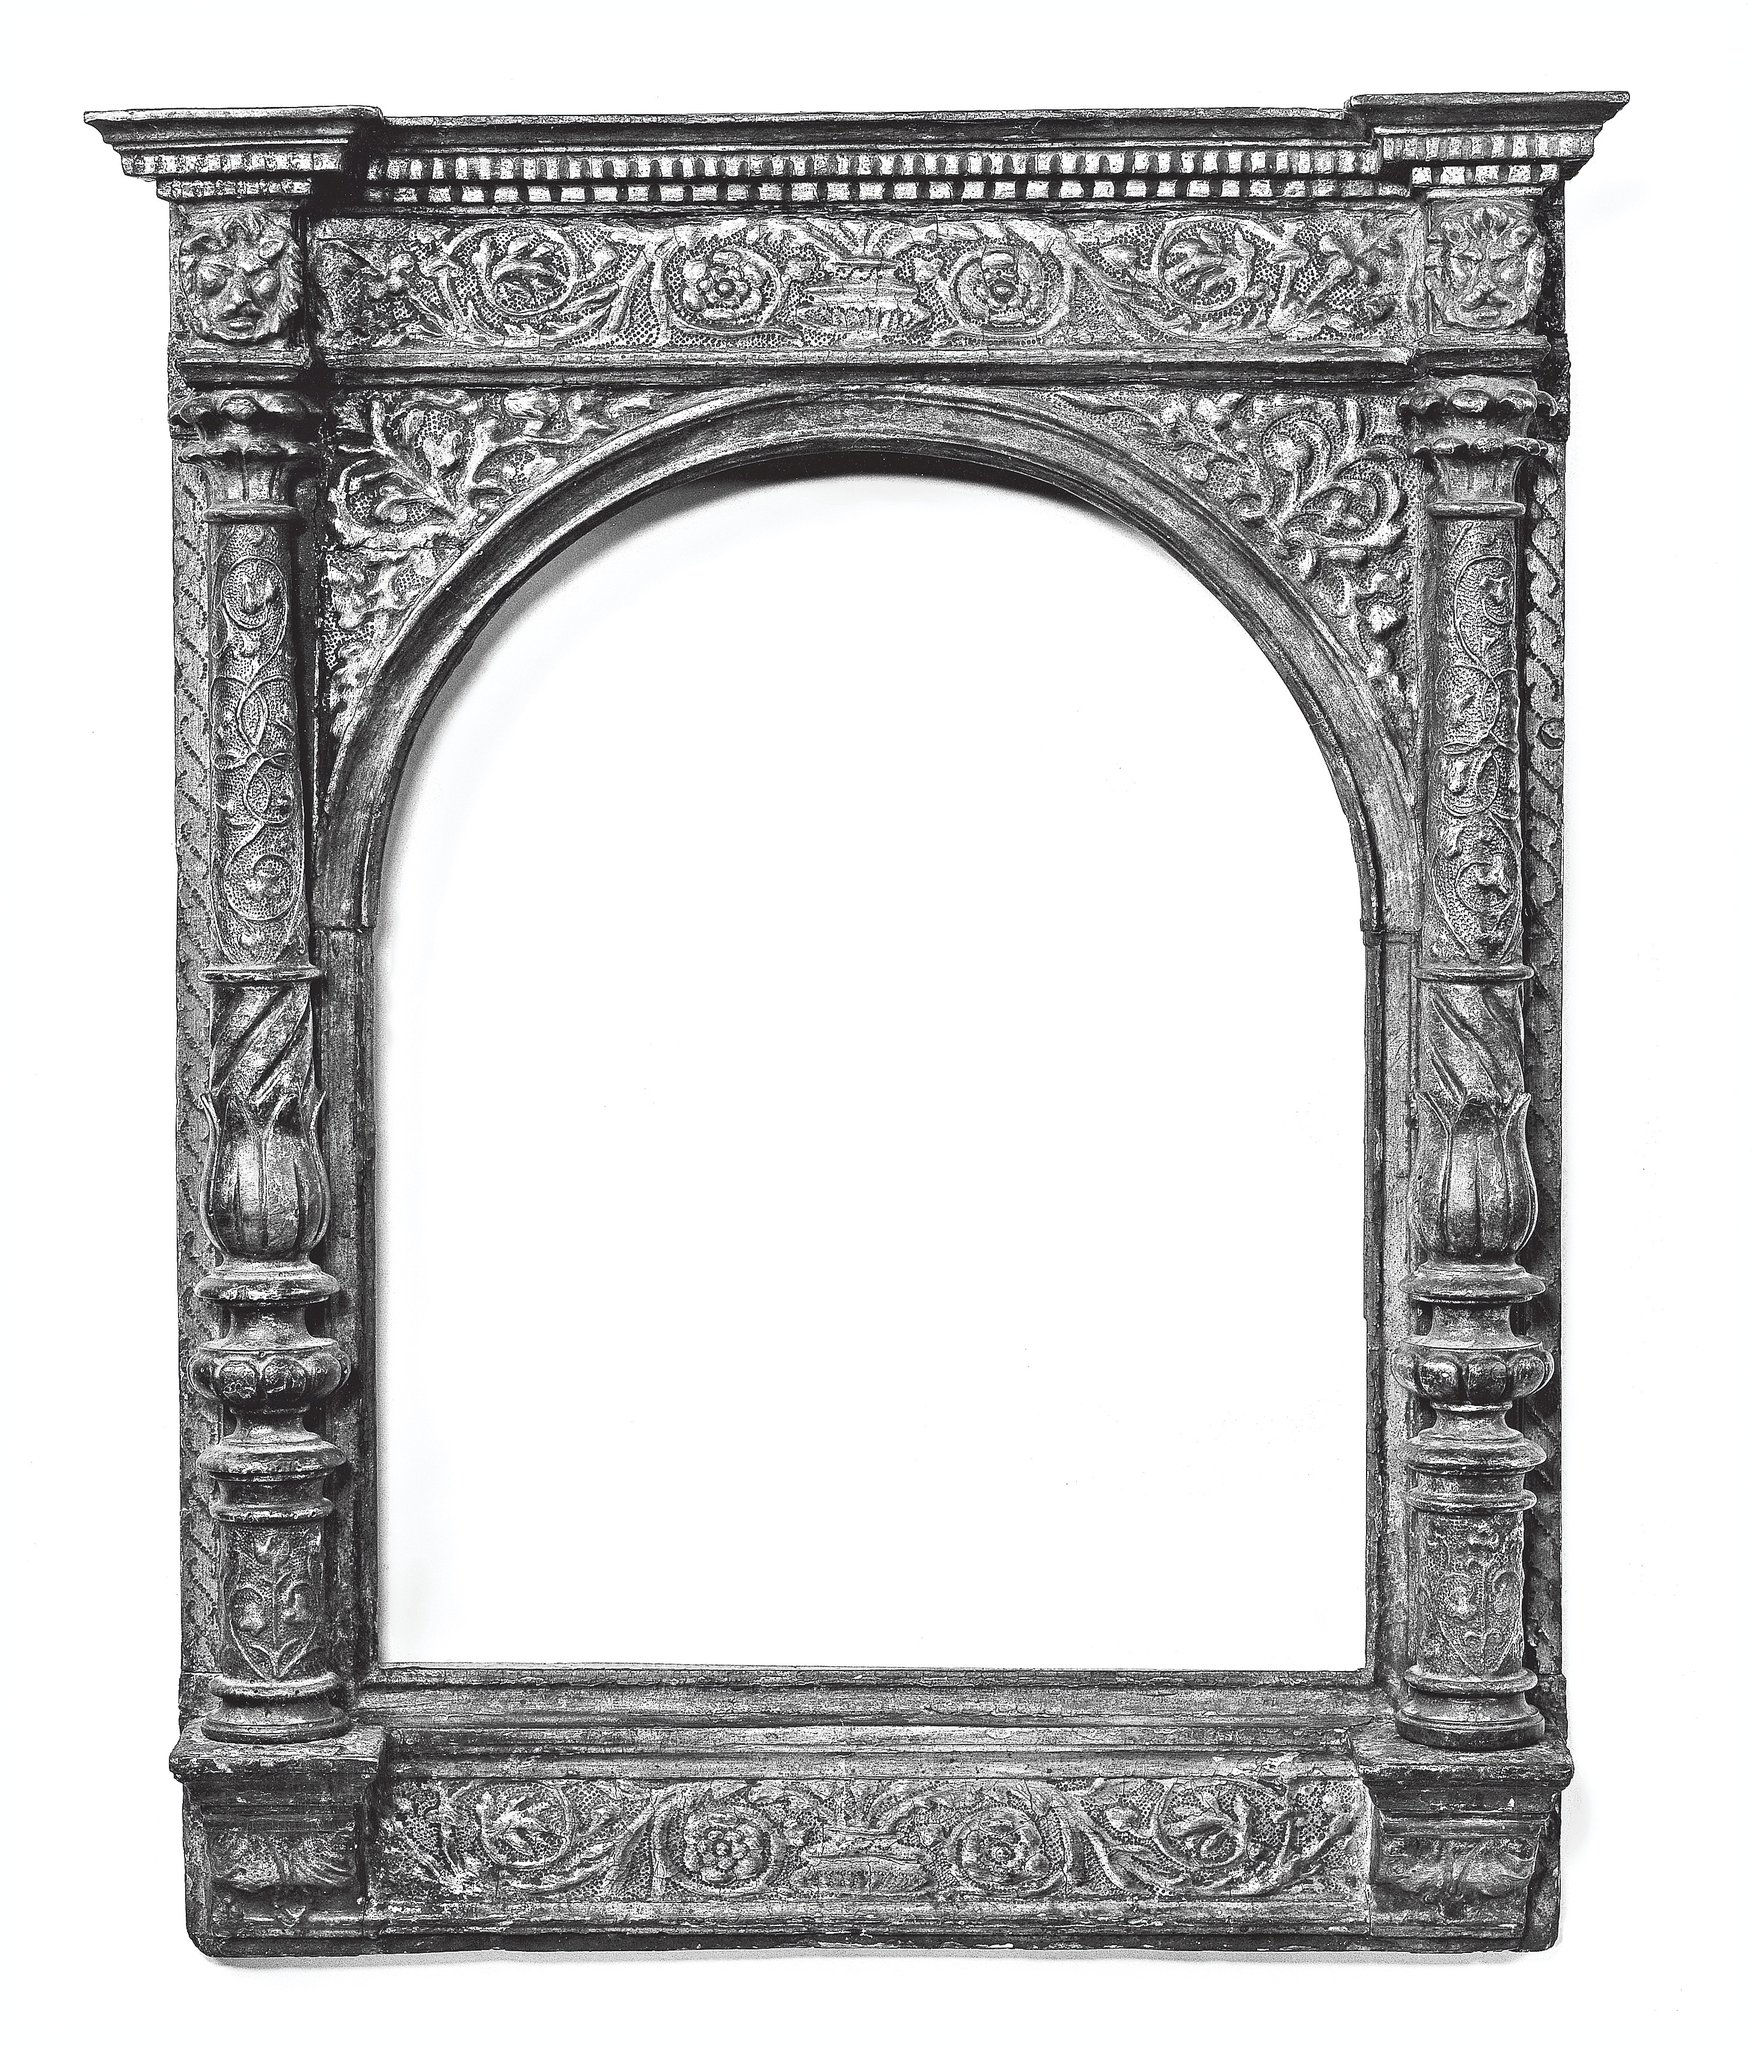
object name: frame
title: Tabernacle frame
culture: italian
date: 1501-1533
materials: wood